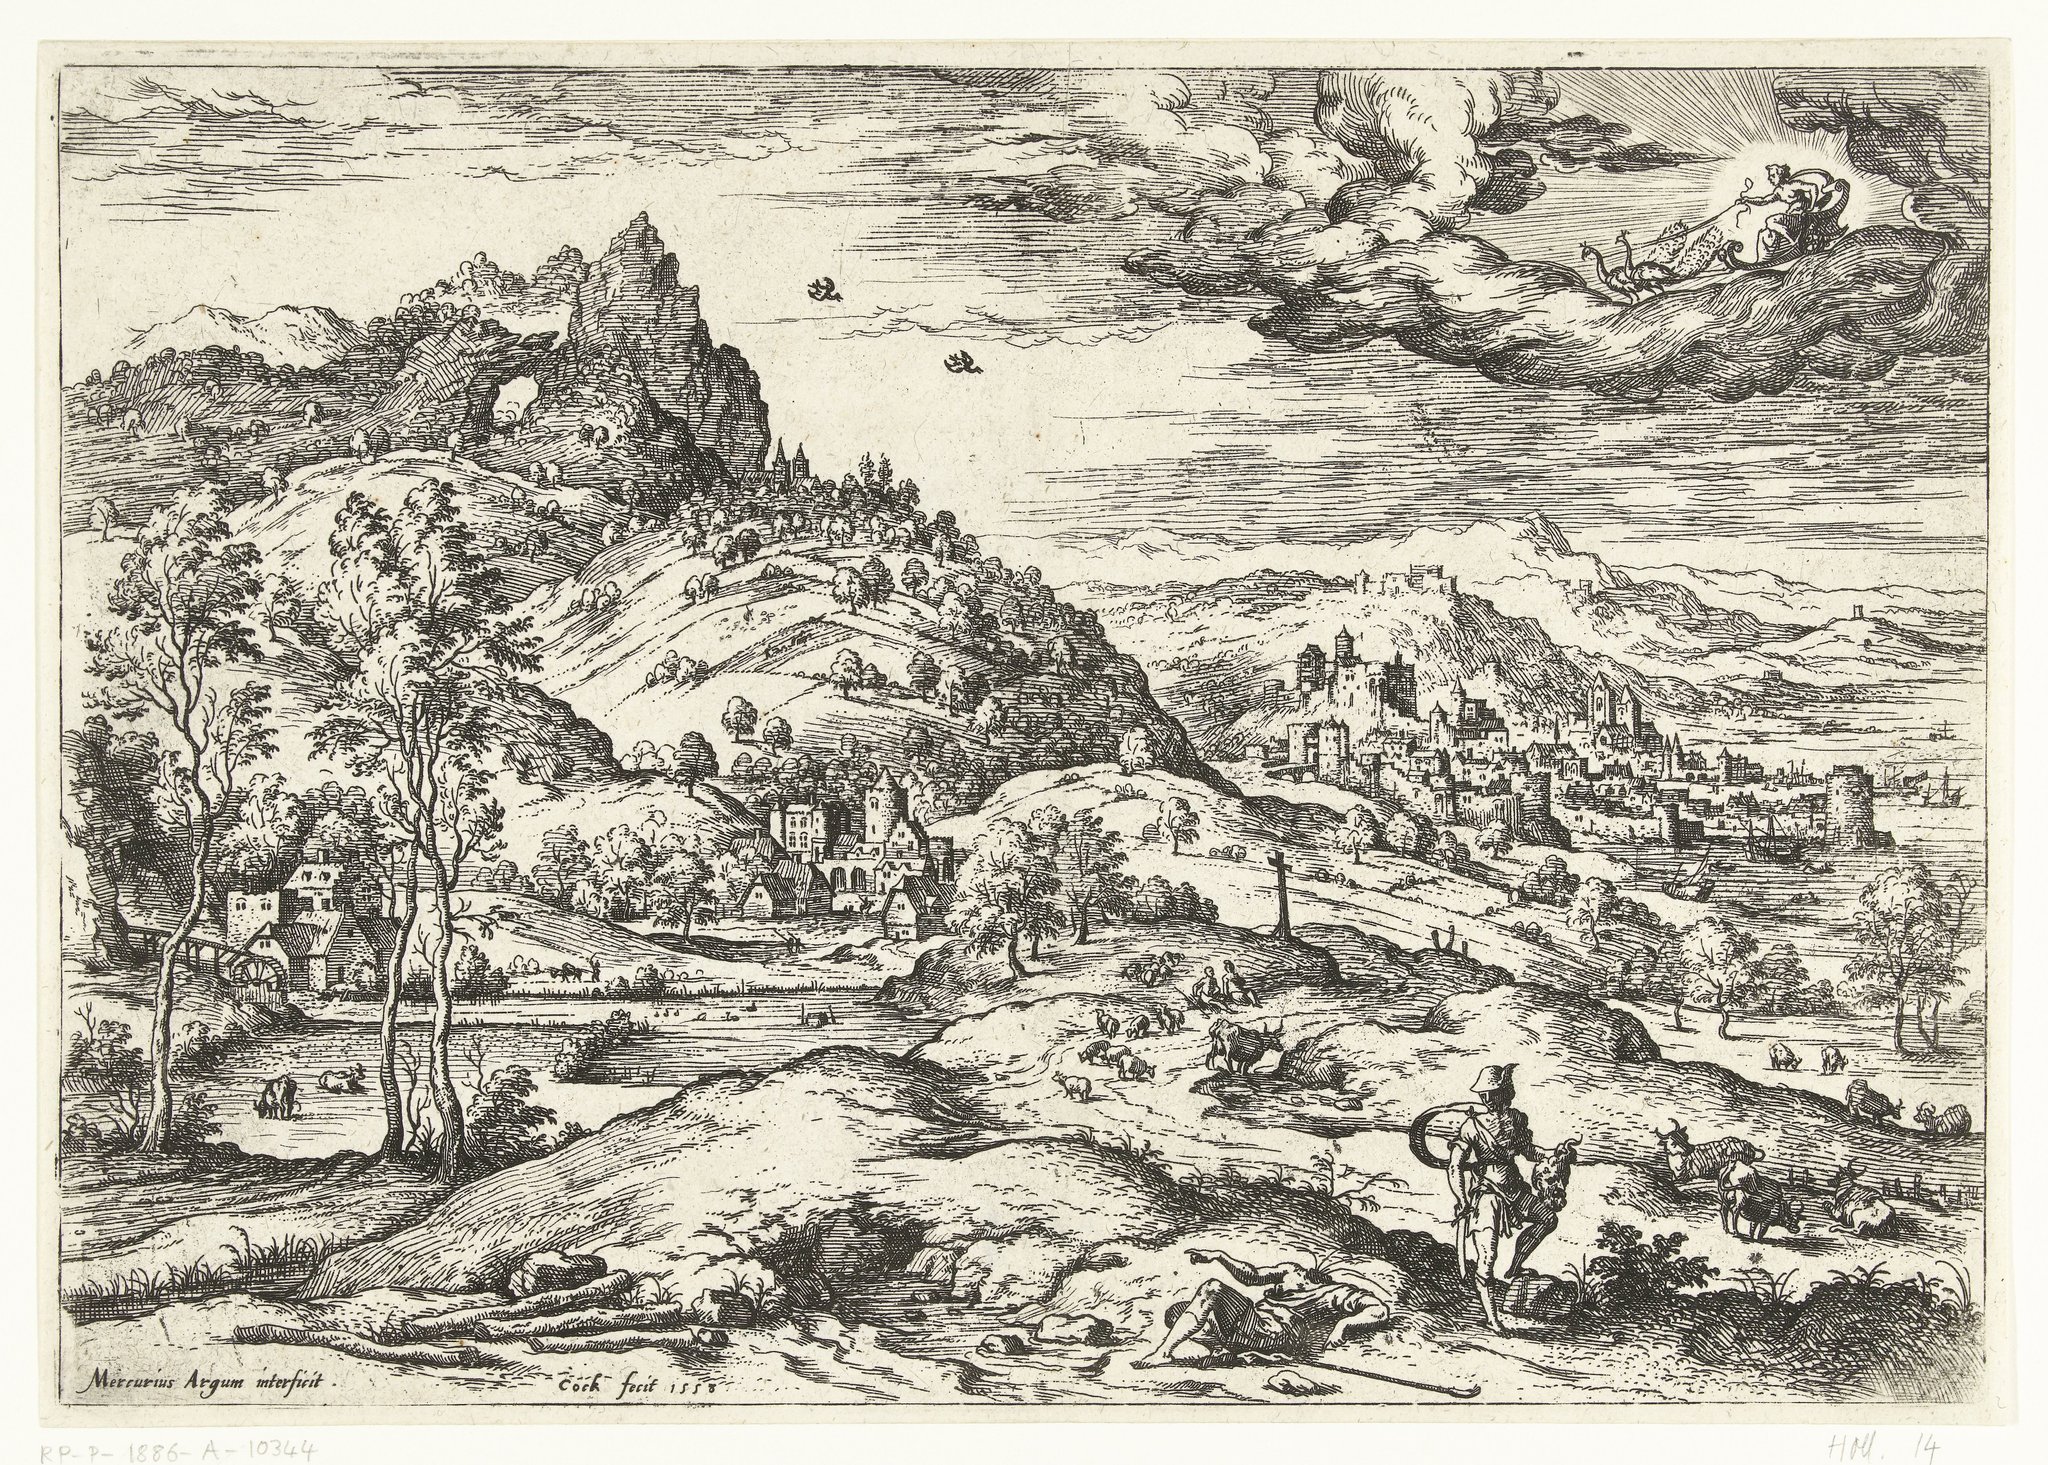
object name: print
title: Mercurius met het hoofd van Argus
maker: hieronymus cock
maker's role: print maker, publisher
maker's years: 1518-1570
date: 1558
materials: paper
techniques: etching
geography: antwerp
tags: mercury beheads argus, argus' eyes changed into peacock's 'eyes' (ocelli): juno sets argus' eyes on her peacock, after argus, while watching io, has been slain by mercury (ovid, metamorphoses i 723)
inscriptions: collector's mark: Lugt 2228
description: Heuvelachtig landschap met een havenstadje in de verte. Rechts voor Mercurius die de reus Argus het hoofd afgehakt heeft. Mercurius houdt het hoofd in zijn hand. In de wolken rijdt Juno in haar koets die getrokken wordt door twee pauwen. Prent uit een serie van 13 landschappen met bijbelse en mythologische scènes.